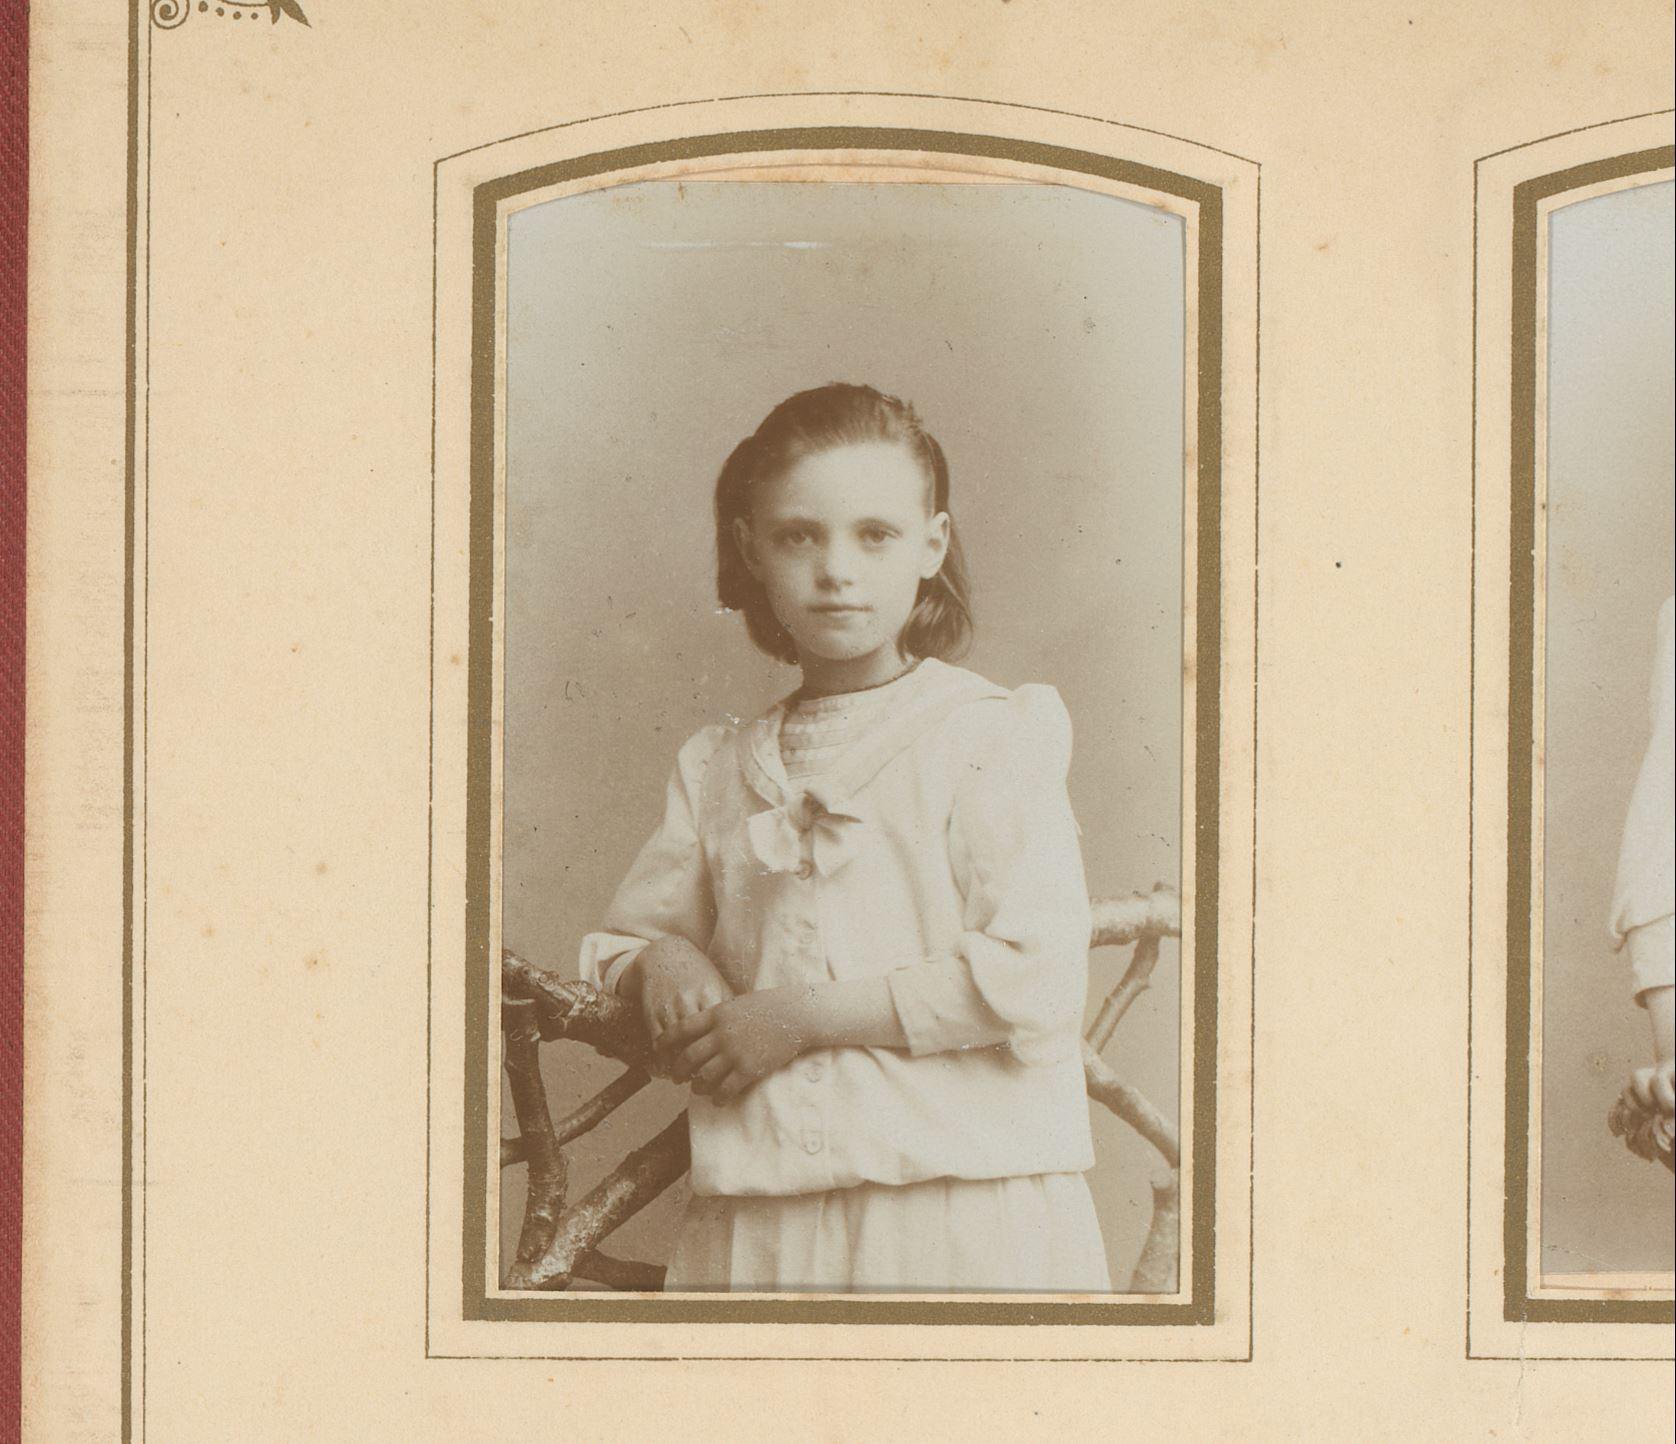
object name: album leaf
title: Portret van een zittend meisje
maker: willem bernard bekkering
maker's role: painter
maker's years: 1858-1902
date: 1886-1902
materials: cardboard, photographic support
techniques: collodion silver print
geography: groningen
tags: sitting figure - aa - female human figure, historical persons - bb - woman, girl (child between toddler and youth)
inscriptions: inscription: ‘W. B. Bekkering/ Firma Godfried de Jong/ Groningen/ Heerestraat/ hoek kl. pelsterstr.’